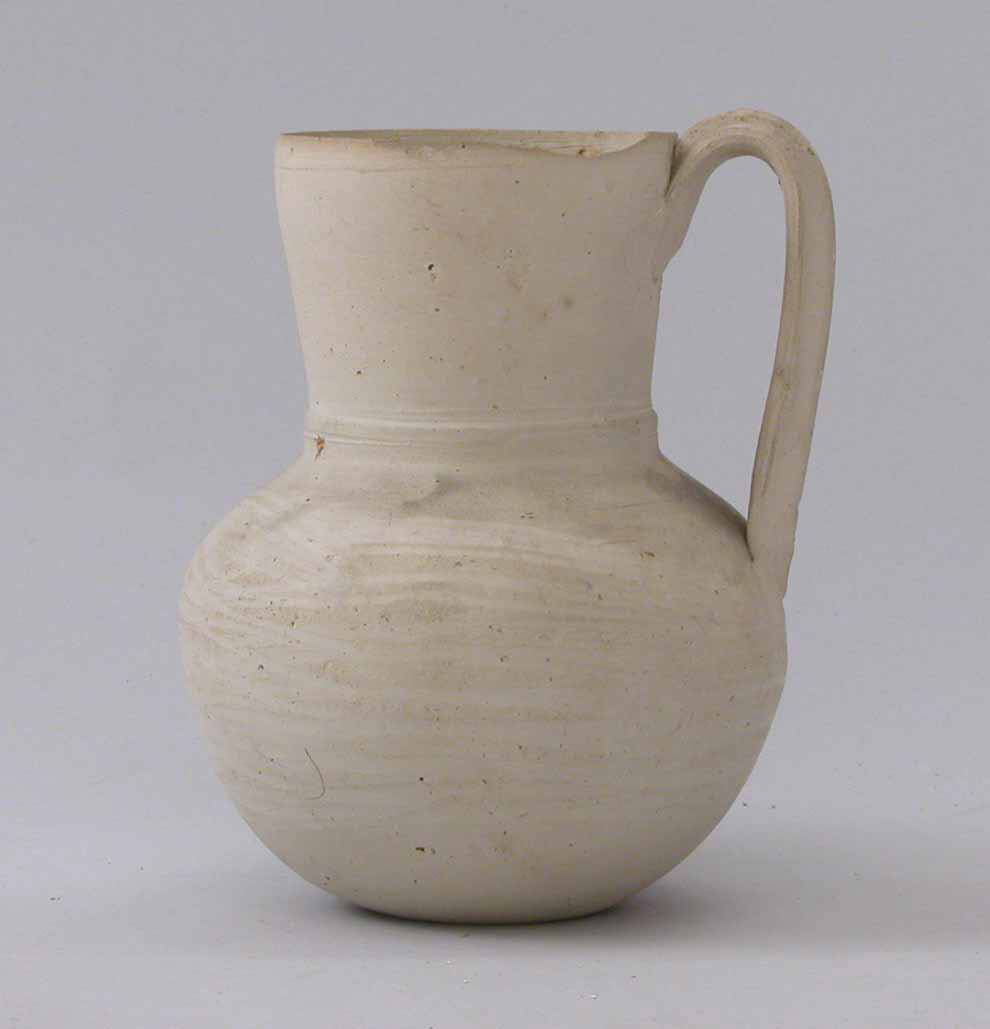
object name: ewer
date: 767-900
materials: earthenware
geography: iran